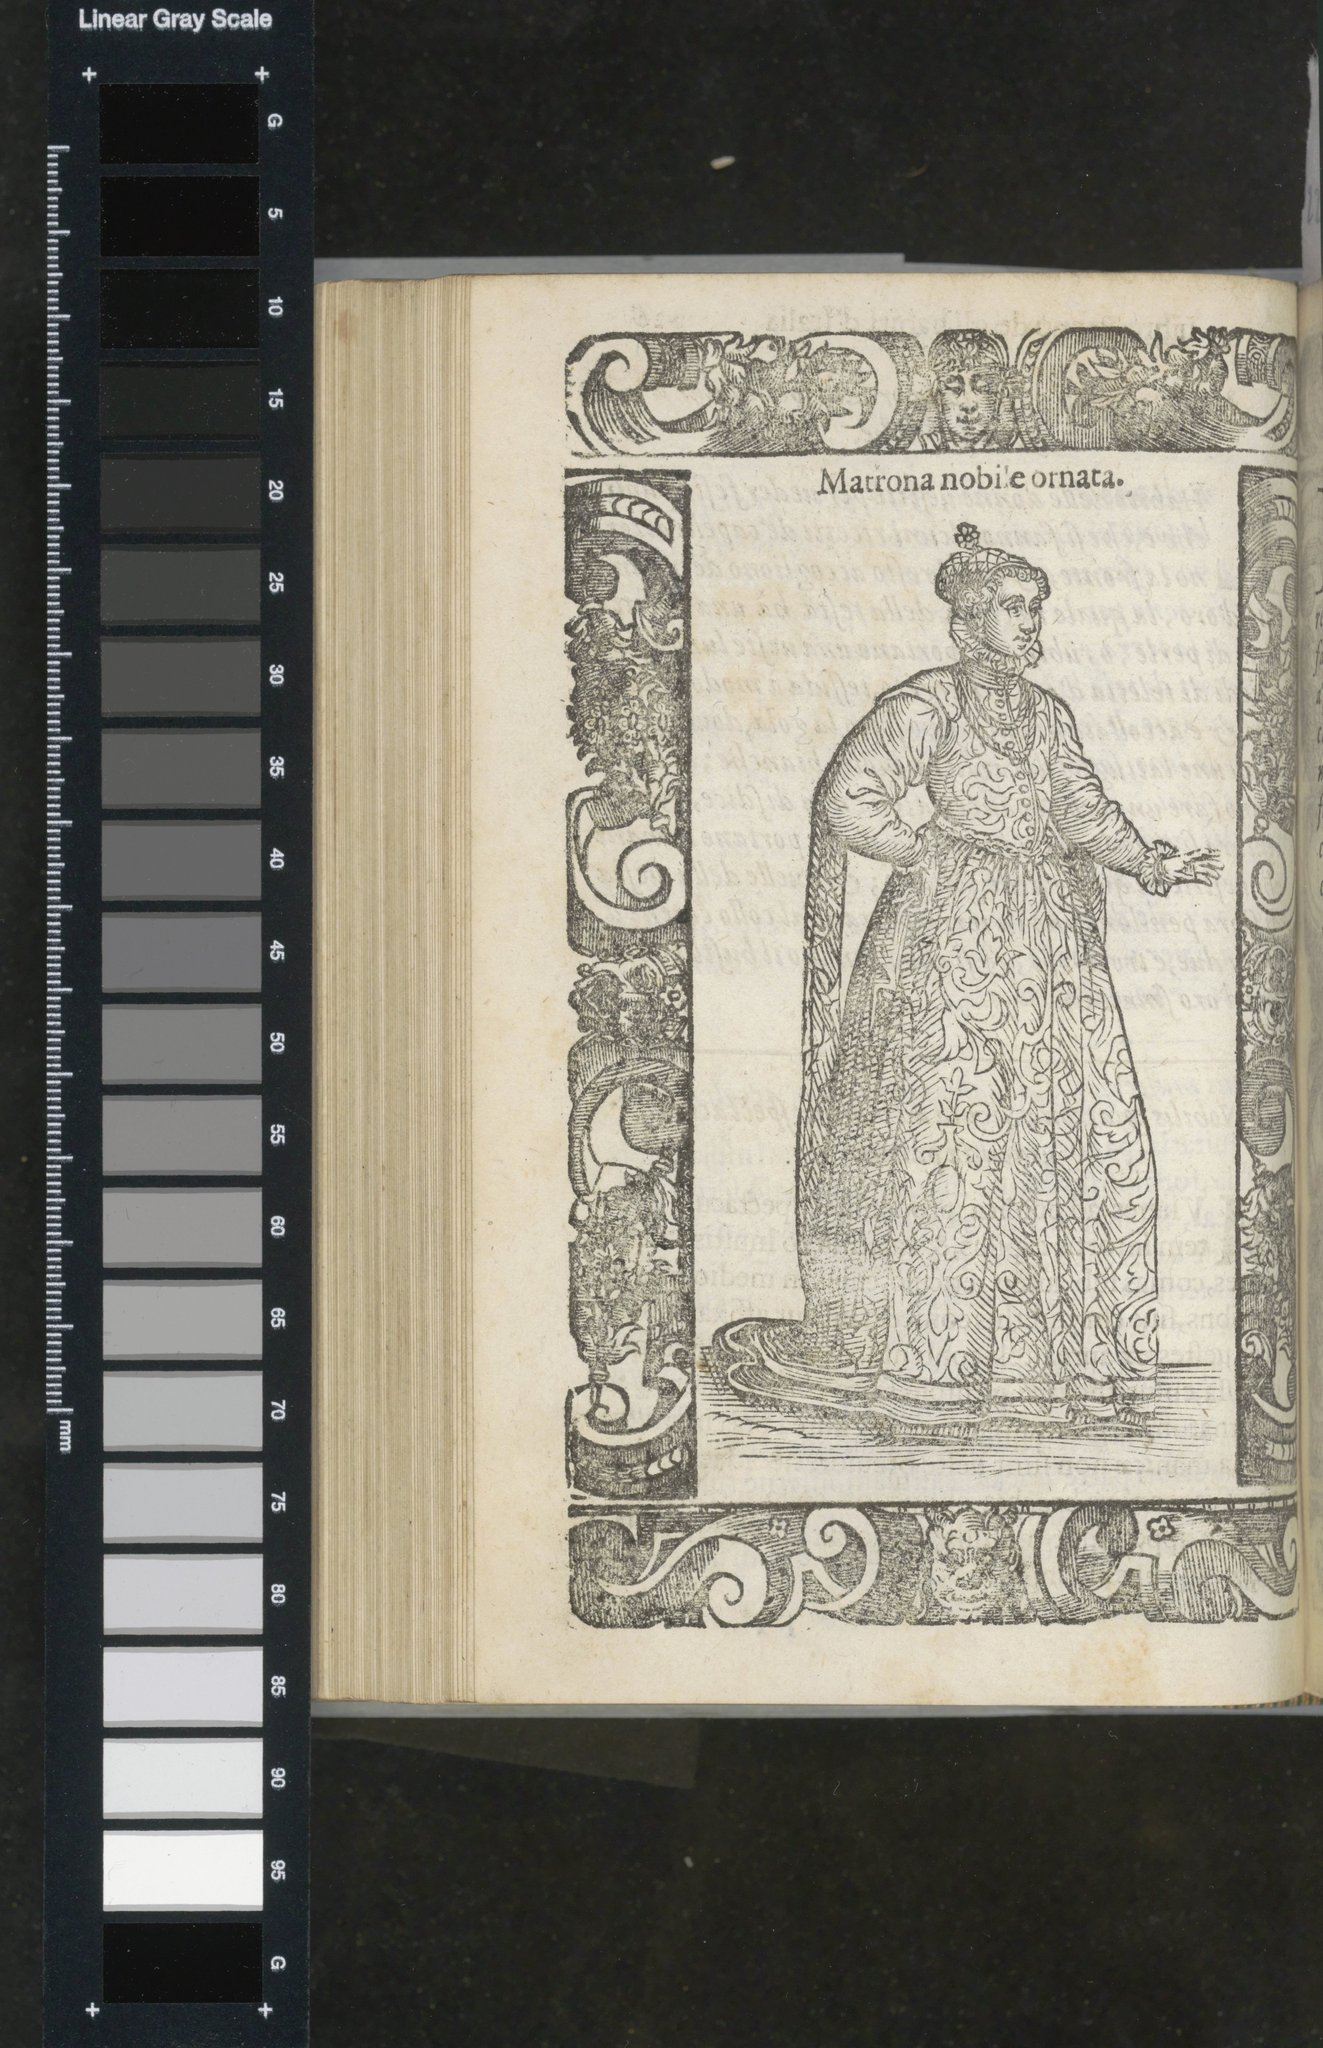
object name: costume print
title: Habiti antichi, et moderni di tutto il mondo...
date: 1598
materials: paper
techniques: woodcut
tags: fashion plates